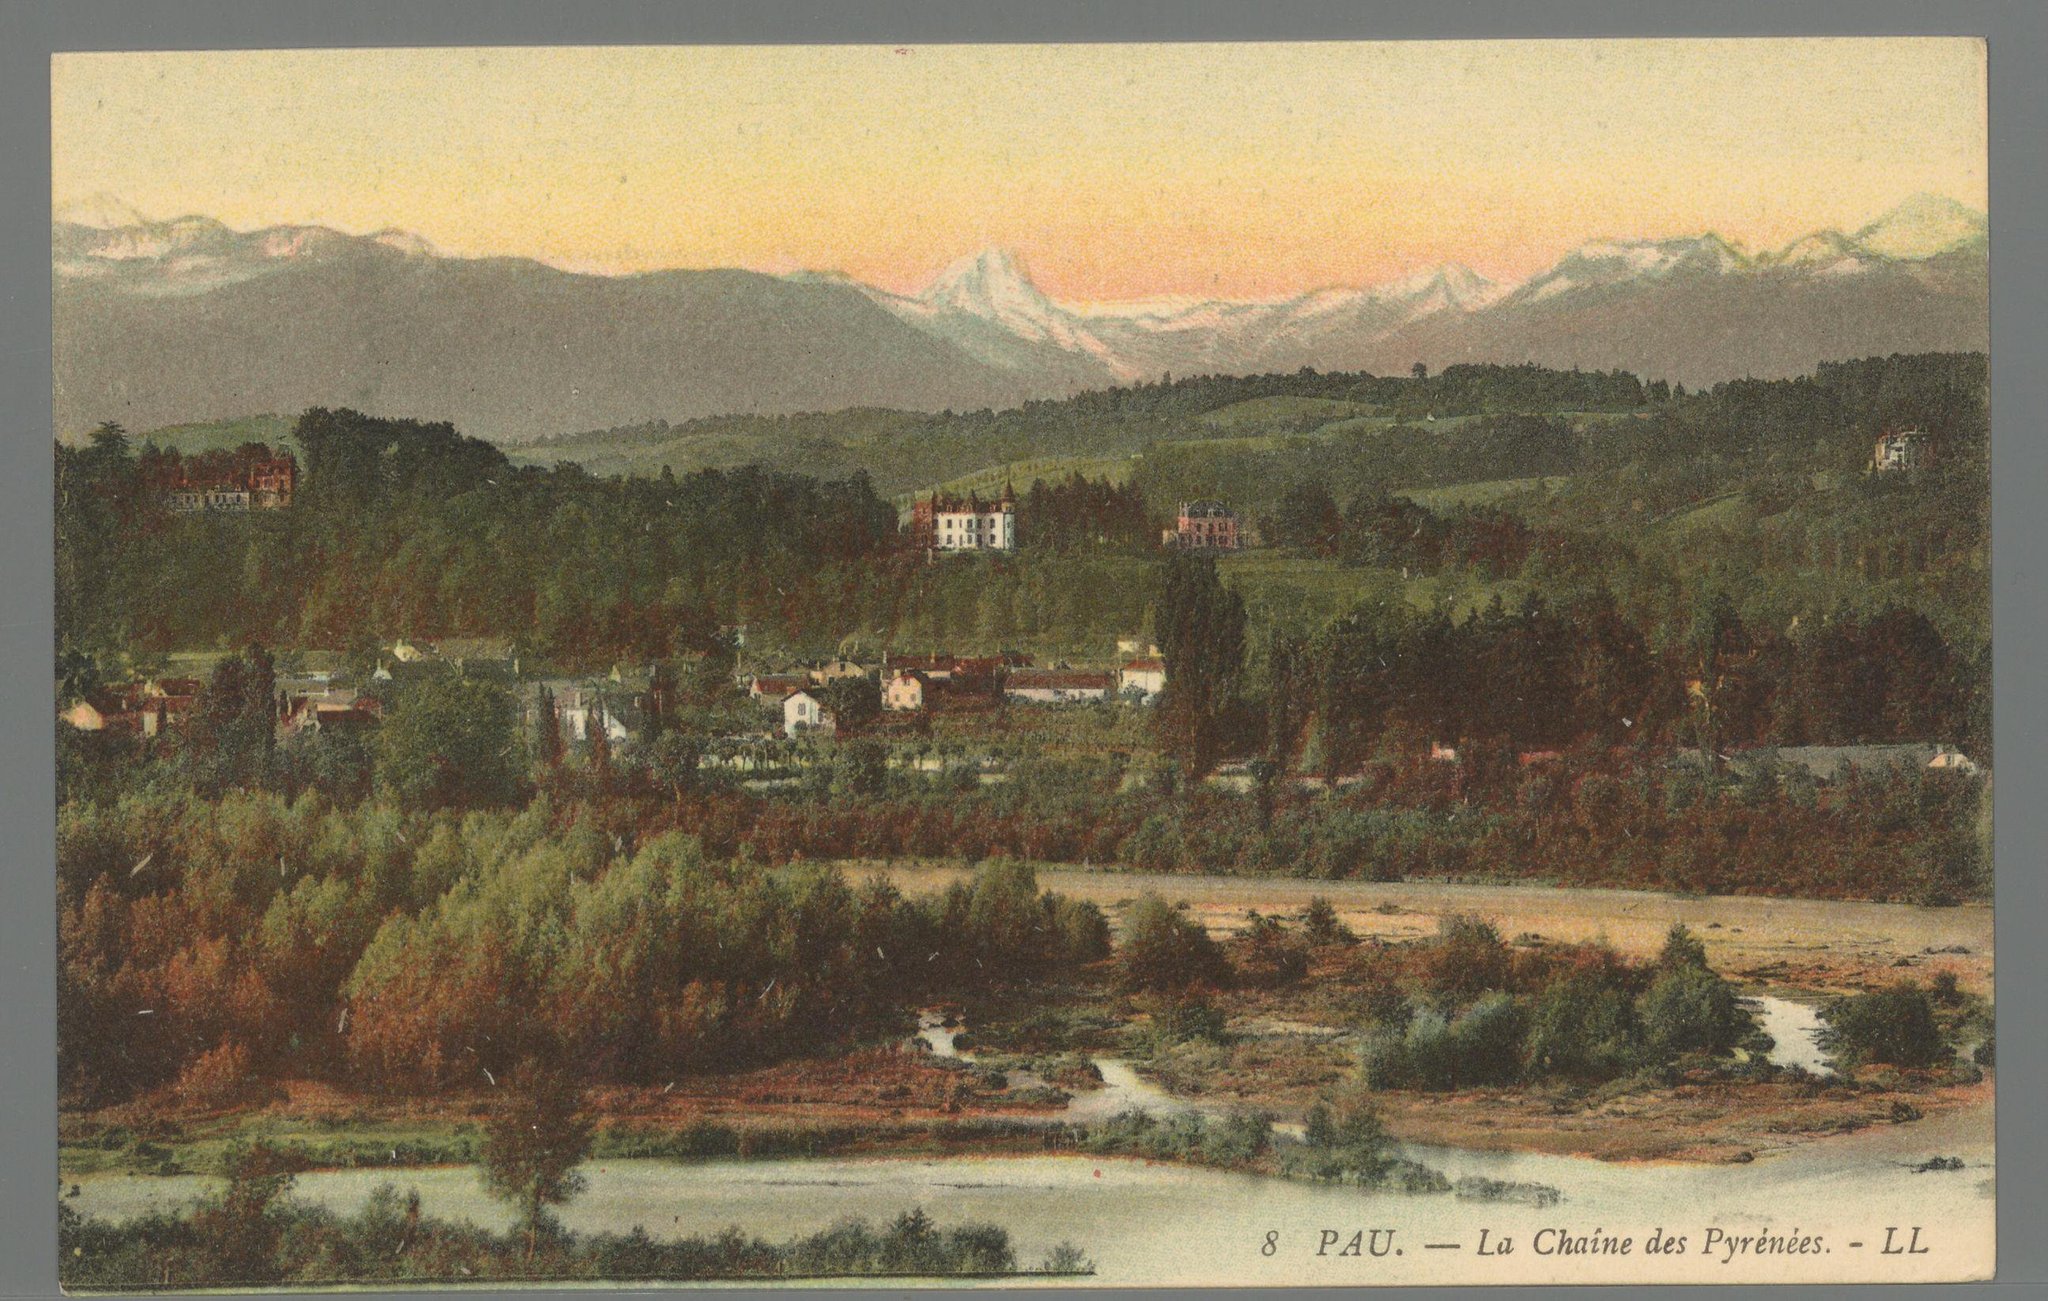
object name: ansichtkaart, prentbriefkaart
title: Pau. La Chaîne des Pyrénées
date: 1904-1906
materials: cardboard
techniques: photograph, lithograph, writing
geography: paris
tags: rural housing, e.g. country-house, villa, cottage, mountain-range, snow peaks